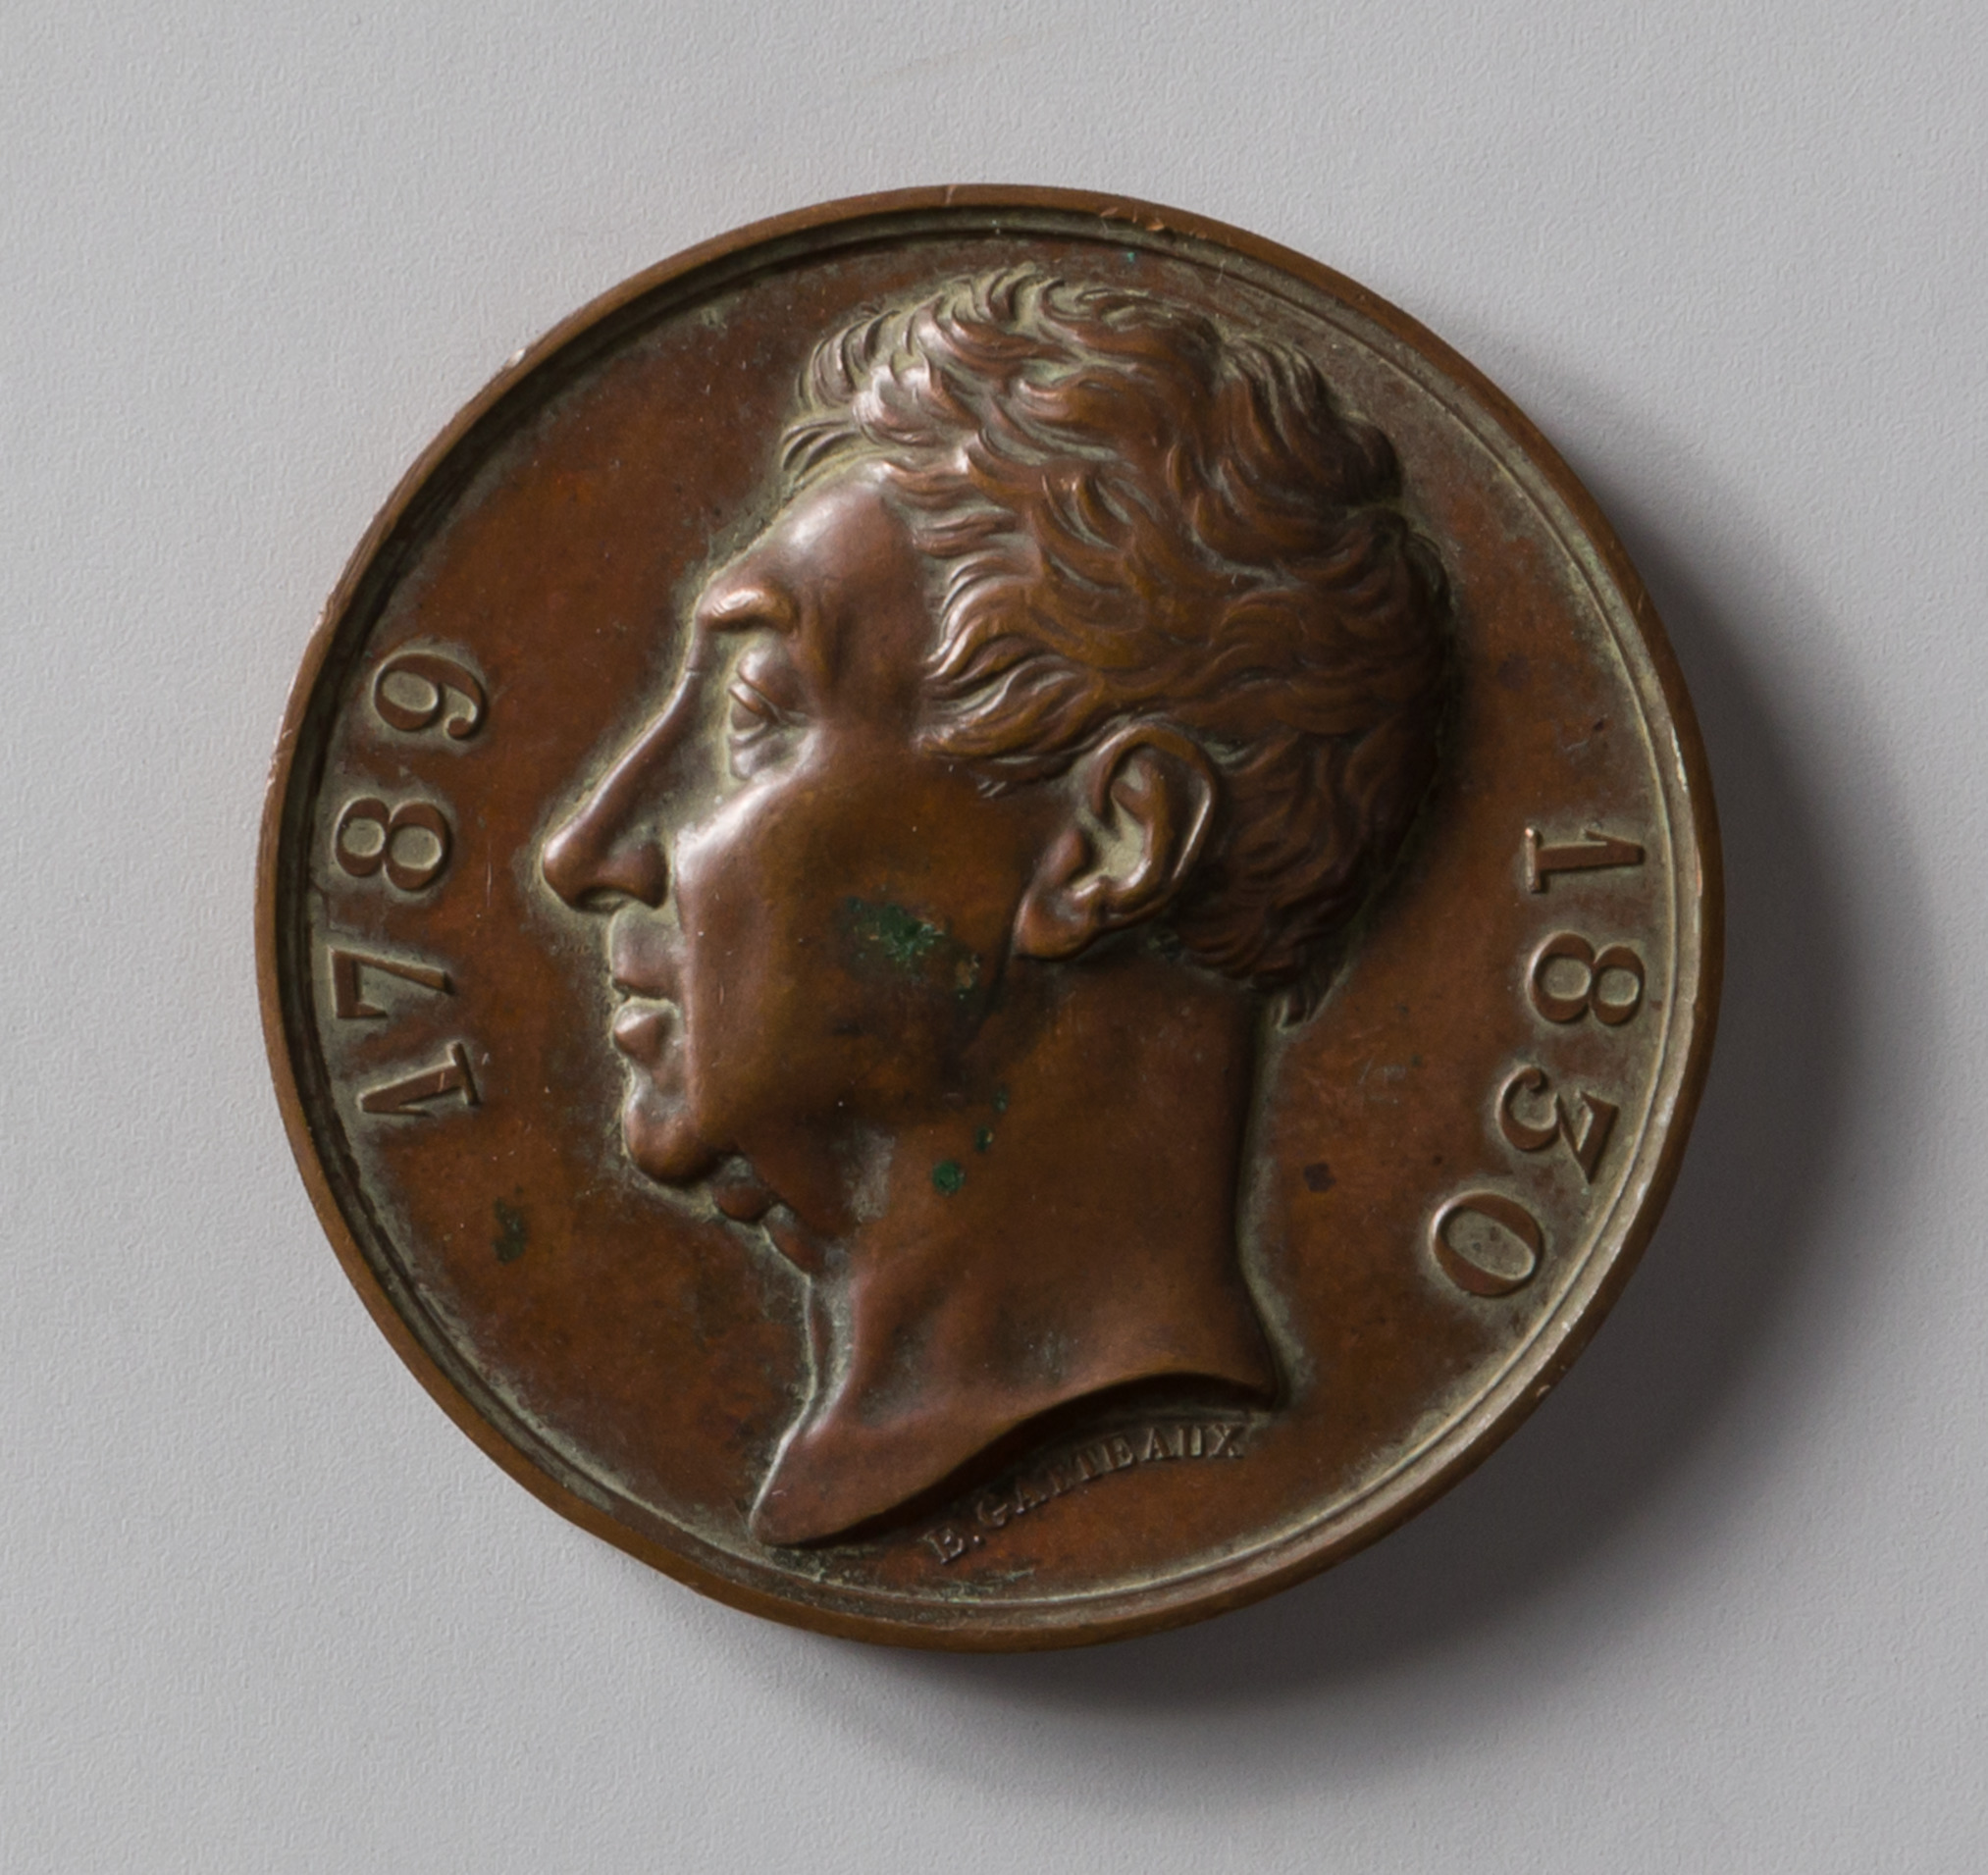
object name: medal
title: Medal of the Marquis de Lafayette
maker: jacques edouard gatteaux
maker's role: maker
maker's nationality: french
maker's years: 1788-1881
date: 1830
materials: bronze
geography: france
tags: men,profiles,marquis de lafayette